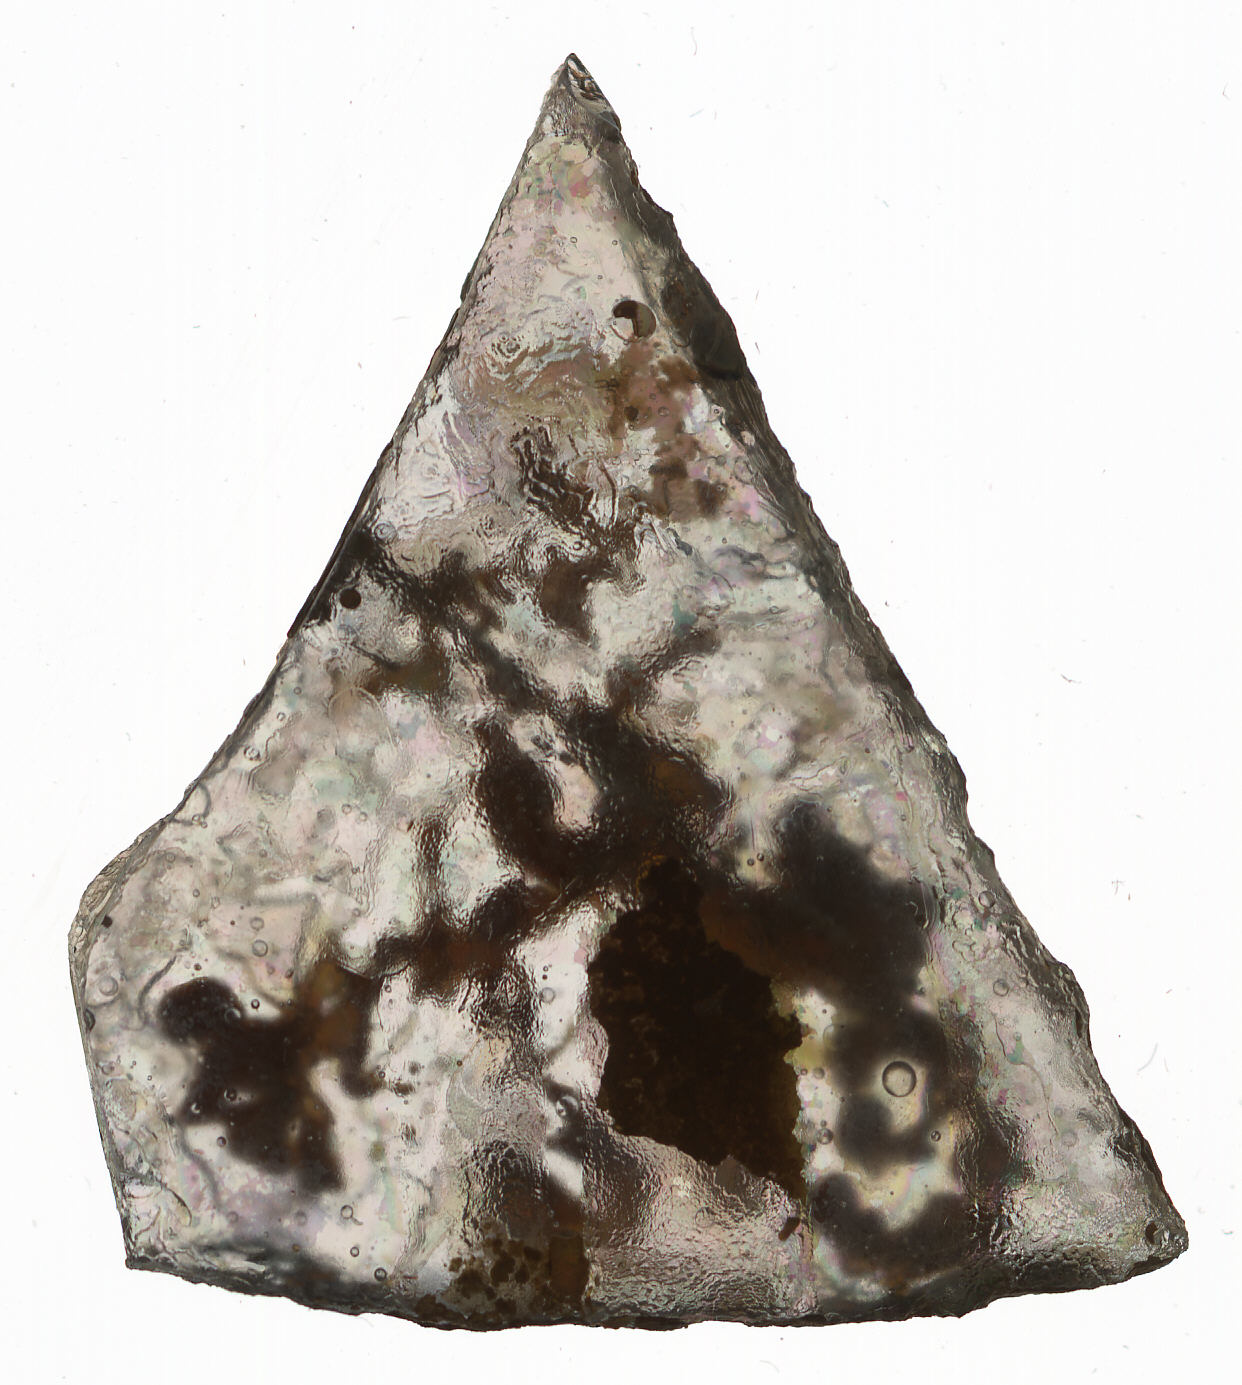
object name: fragment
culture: crusader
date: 1201-1300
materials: glass